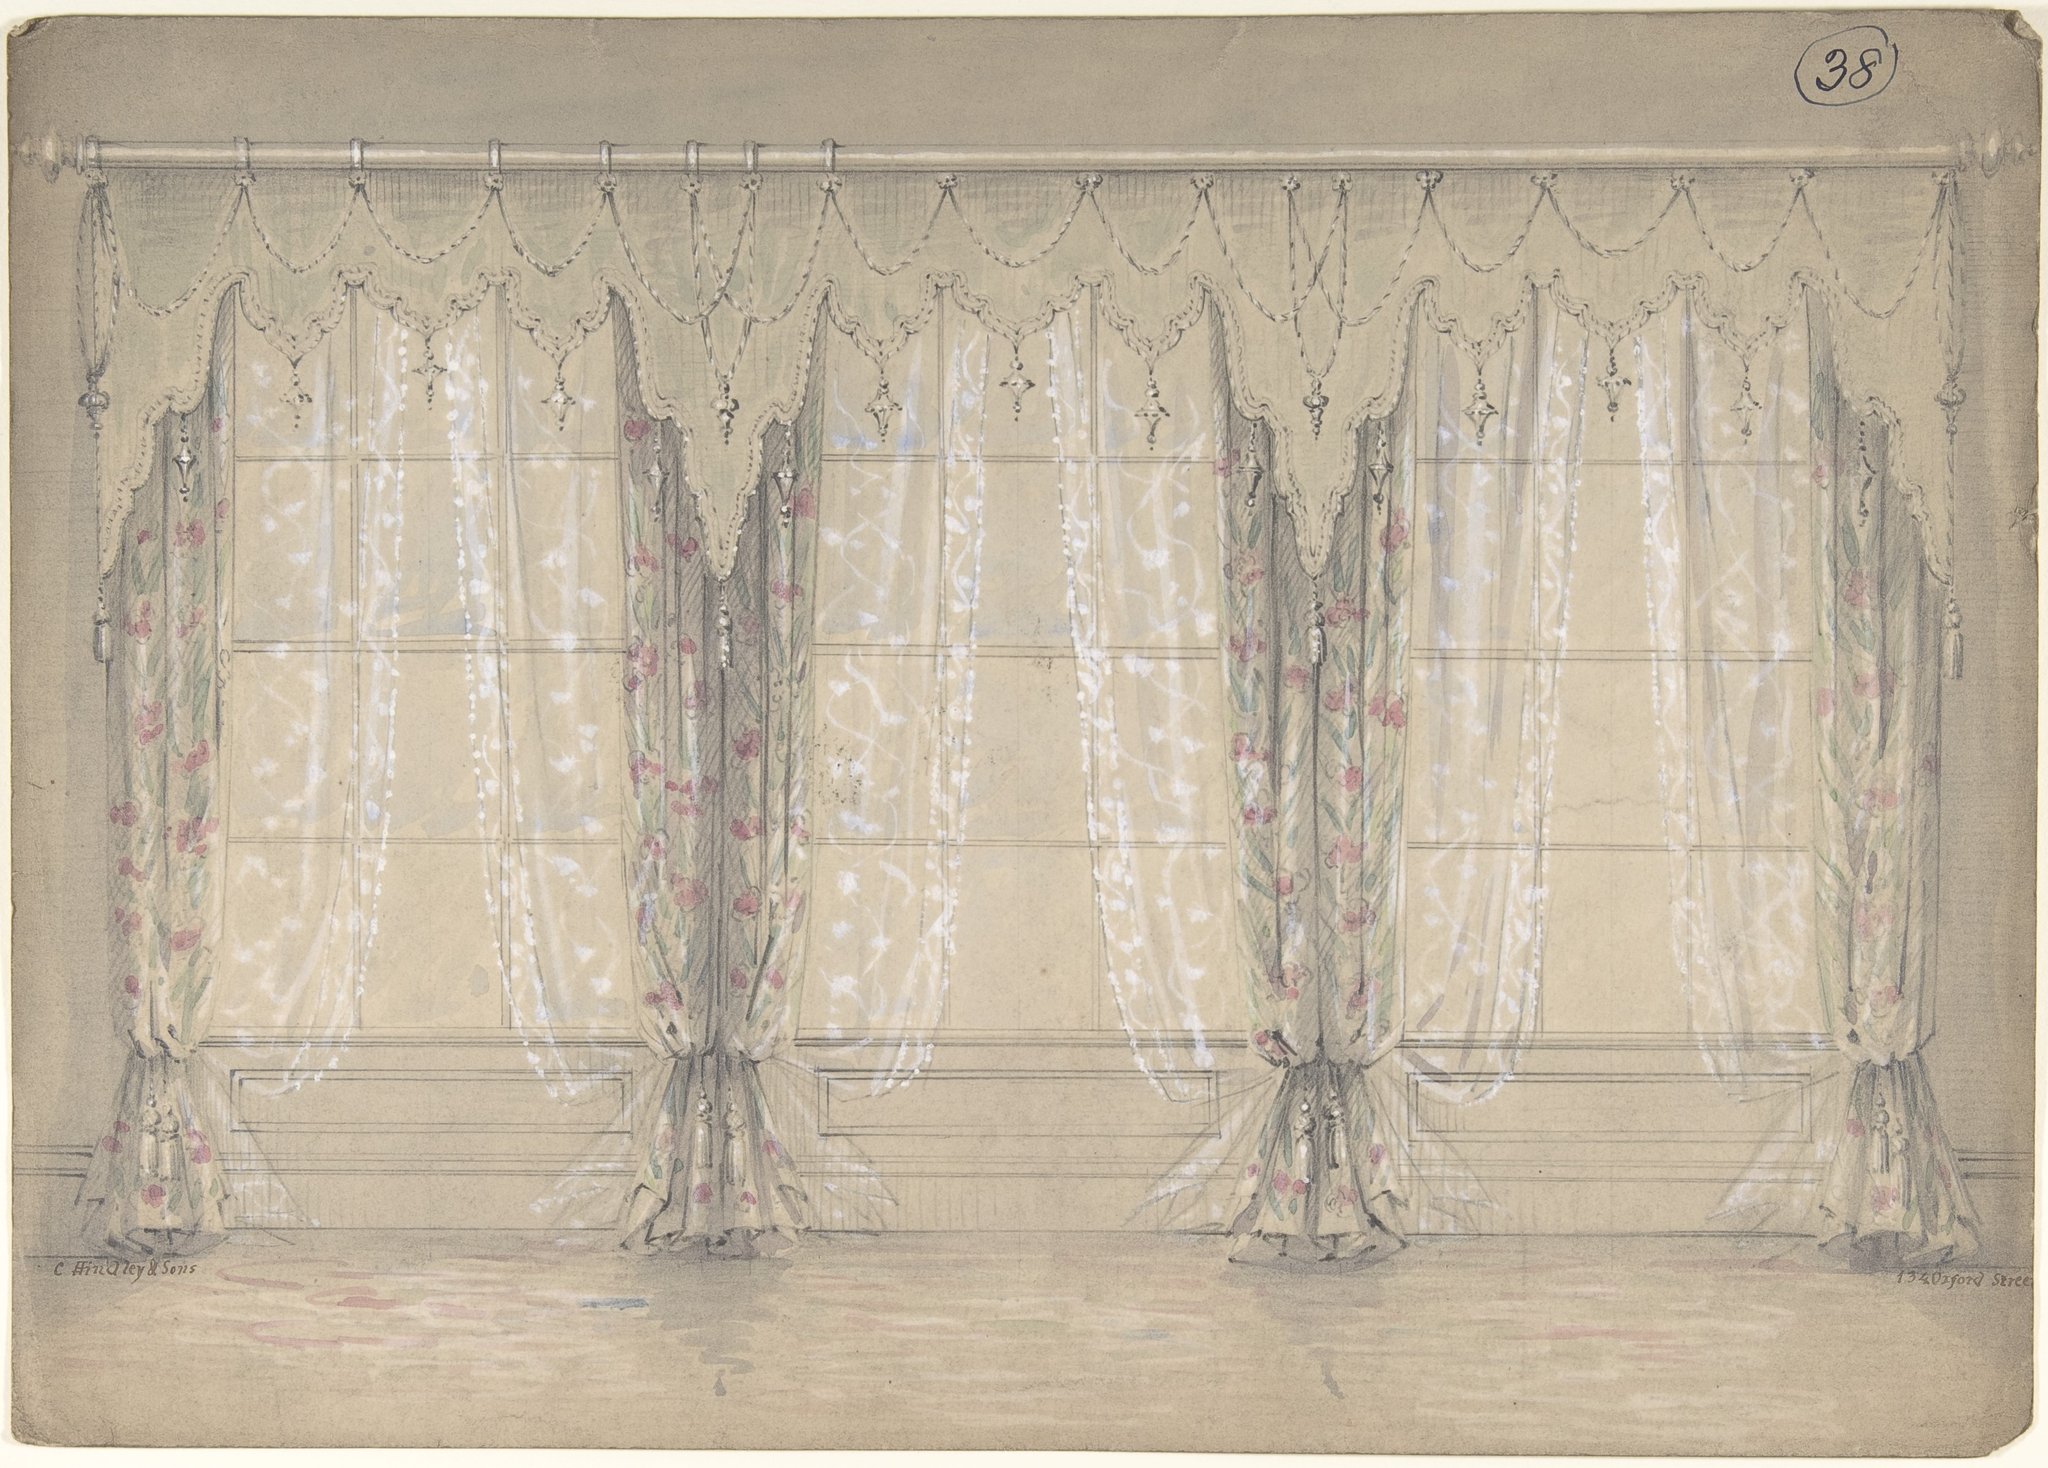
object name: drawing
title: Design for a Wall with Three Windows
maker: charles hindley and sons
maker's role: artist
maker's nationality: british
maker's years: 1841-1917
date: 1841-1884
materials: graphite, watercolor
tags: windows,curtains